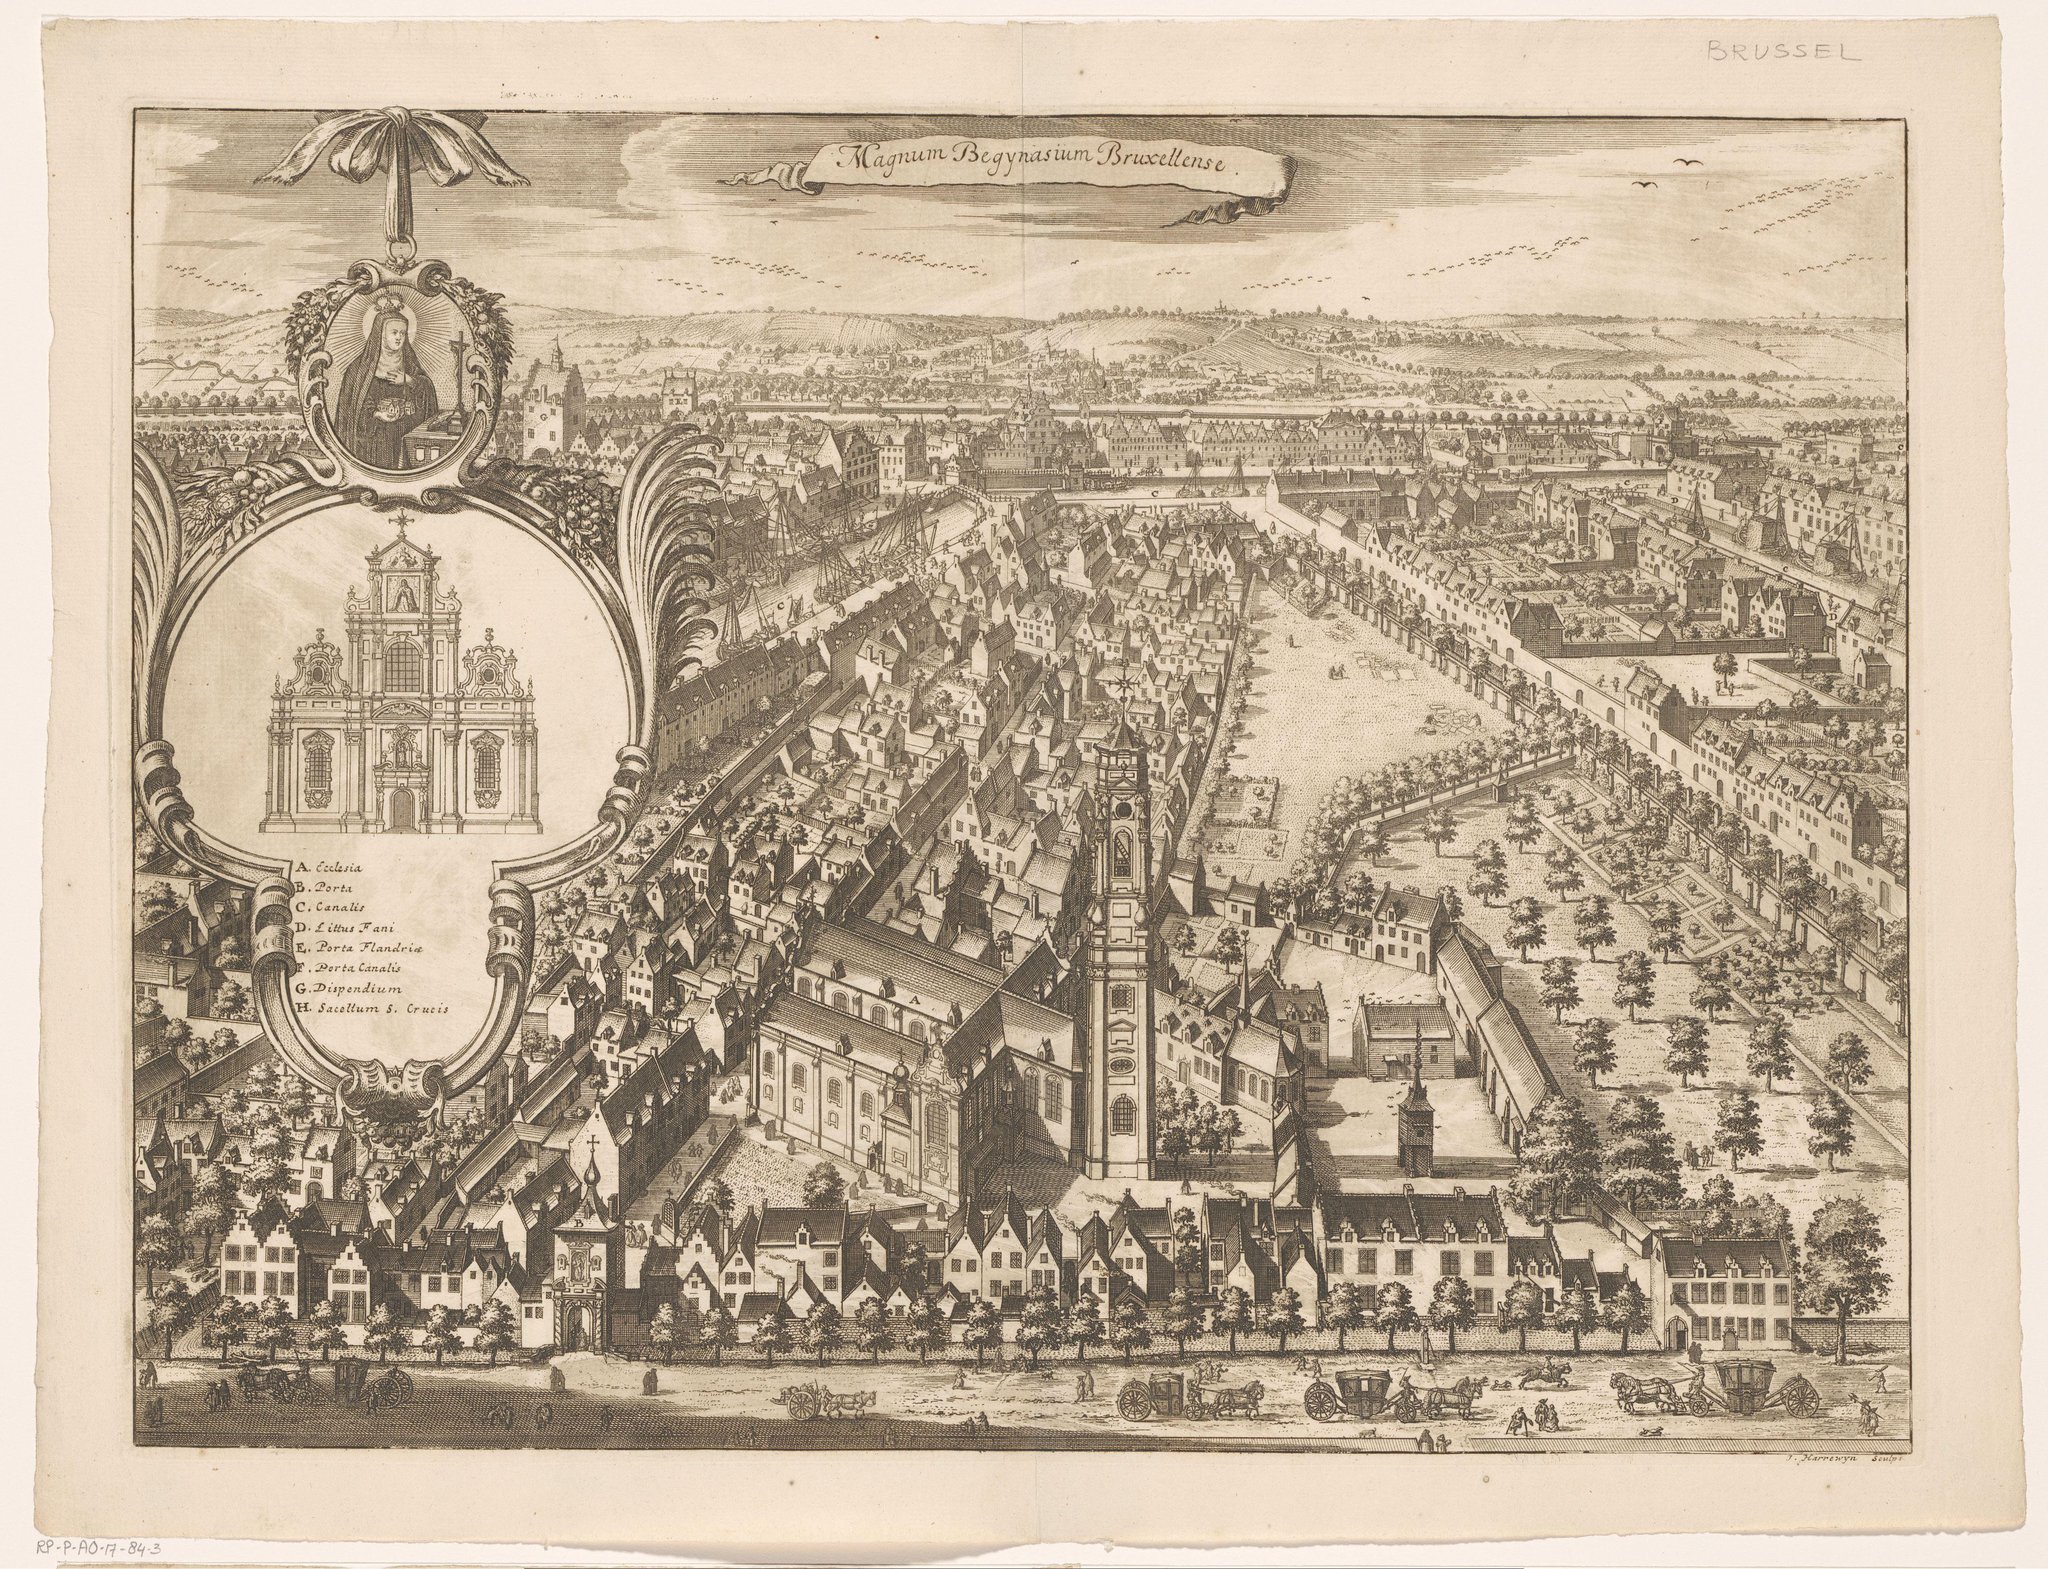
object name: book illustration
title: Gezicht op de Sint-Jan Baptist ten Begijnhofkerk, te Brussel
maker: jacobus harrewijn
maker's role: print maker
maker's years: 1660-1740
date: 1727-1734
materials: paper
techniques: engraving, etching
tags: alms-house (dutch: 'hofje'), church (exterior)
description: Prent ook gebruikt in: Sanderus, Antonius. Groot kerkelyk toneel des Hertogdoms van Brabant (...). Den Haag: Christiaan van Lom, 1727. En in: Sanderus, Antonius. Antonii Sanderi presbyteri Chorographia sacra Brabantiæ. 3 delen. Den Haag: Christiaan van Lom, 1726-1727, dl. 3 (1727). En in: Sanderus, Antonius. Le grand theatre sacré du duché de Brabant (...). 4 delen. Den Haag: Gerard Block, 1729-1734.